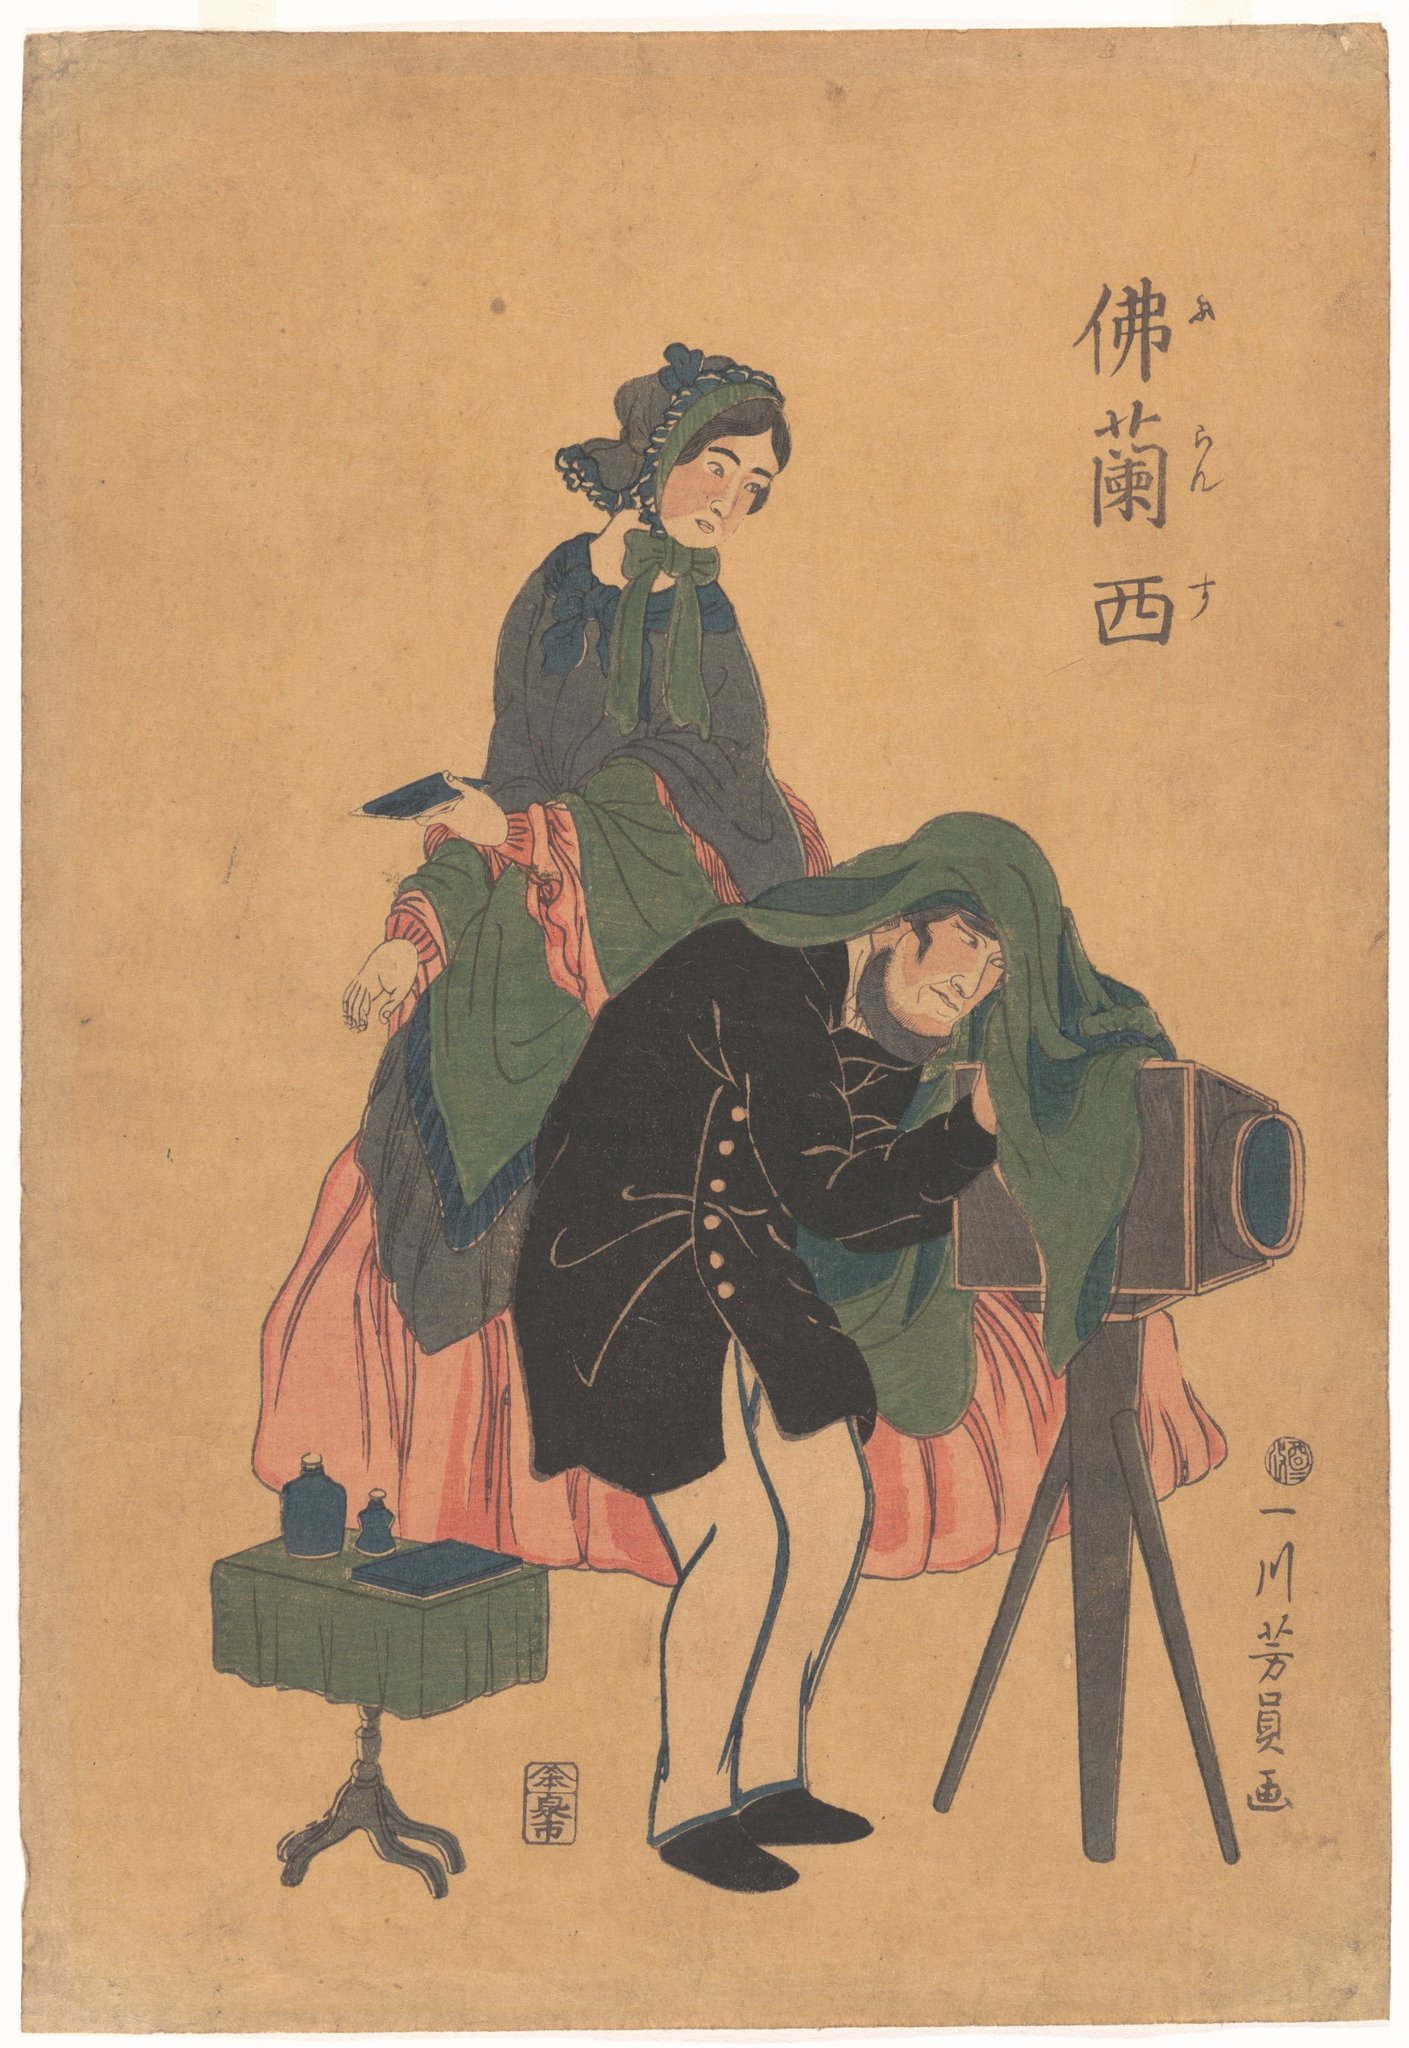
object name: print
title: French Photographer with His Wife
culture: japanese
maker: utagawa yoshikazu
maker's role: artist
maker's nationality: japanese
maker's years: 1845-1870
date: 1861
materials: ink, paper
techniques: woodblock print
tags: photography,men,women